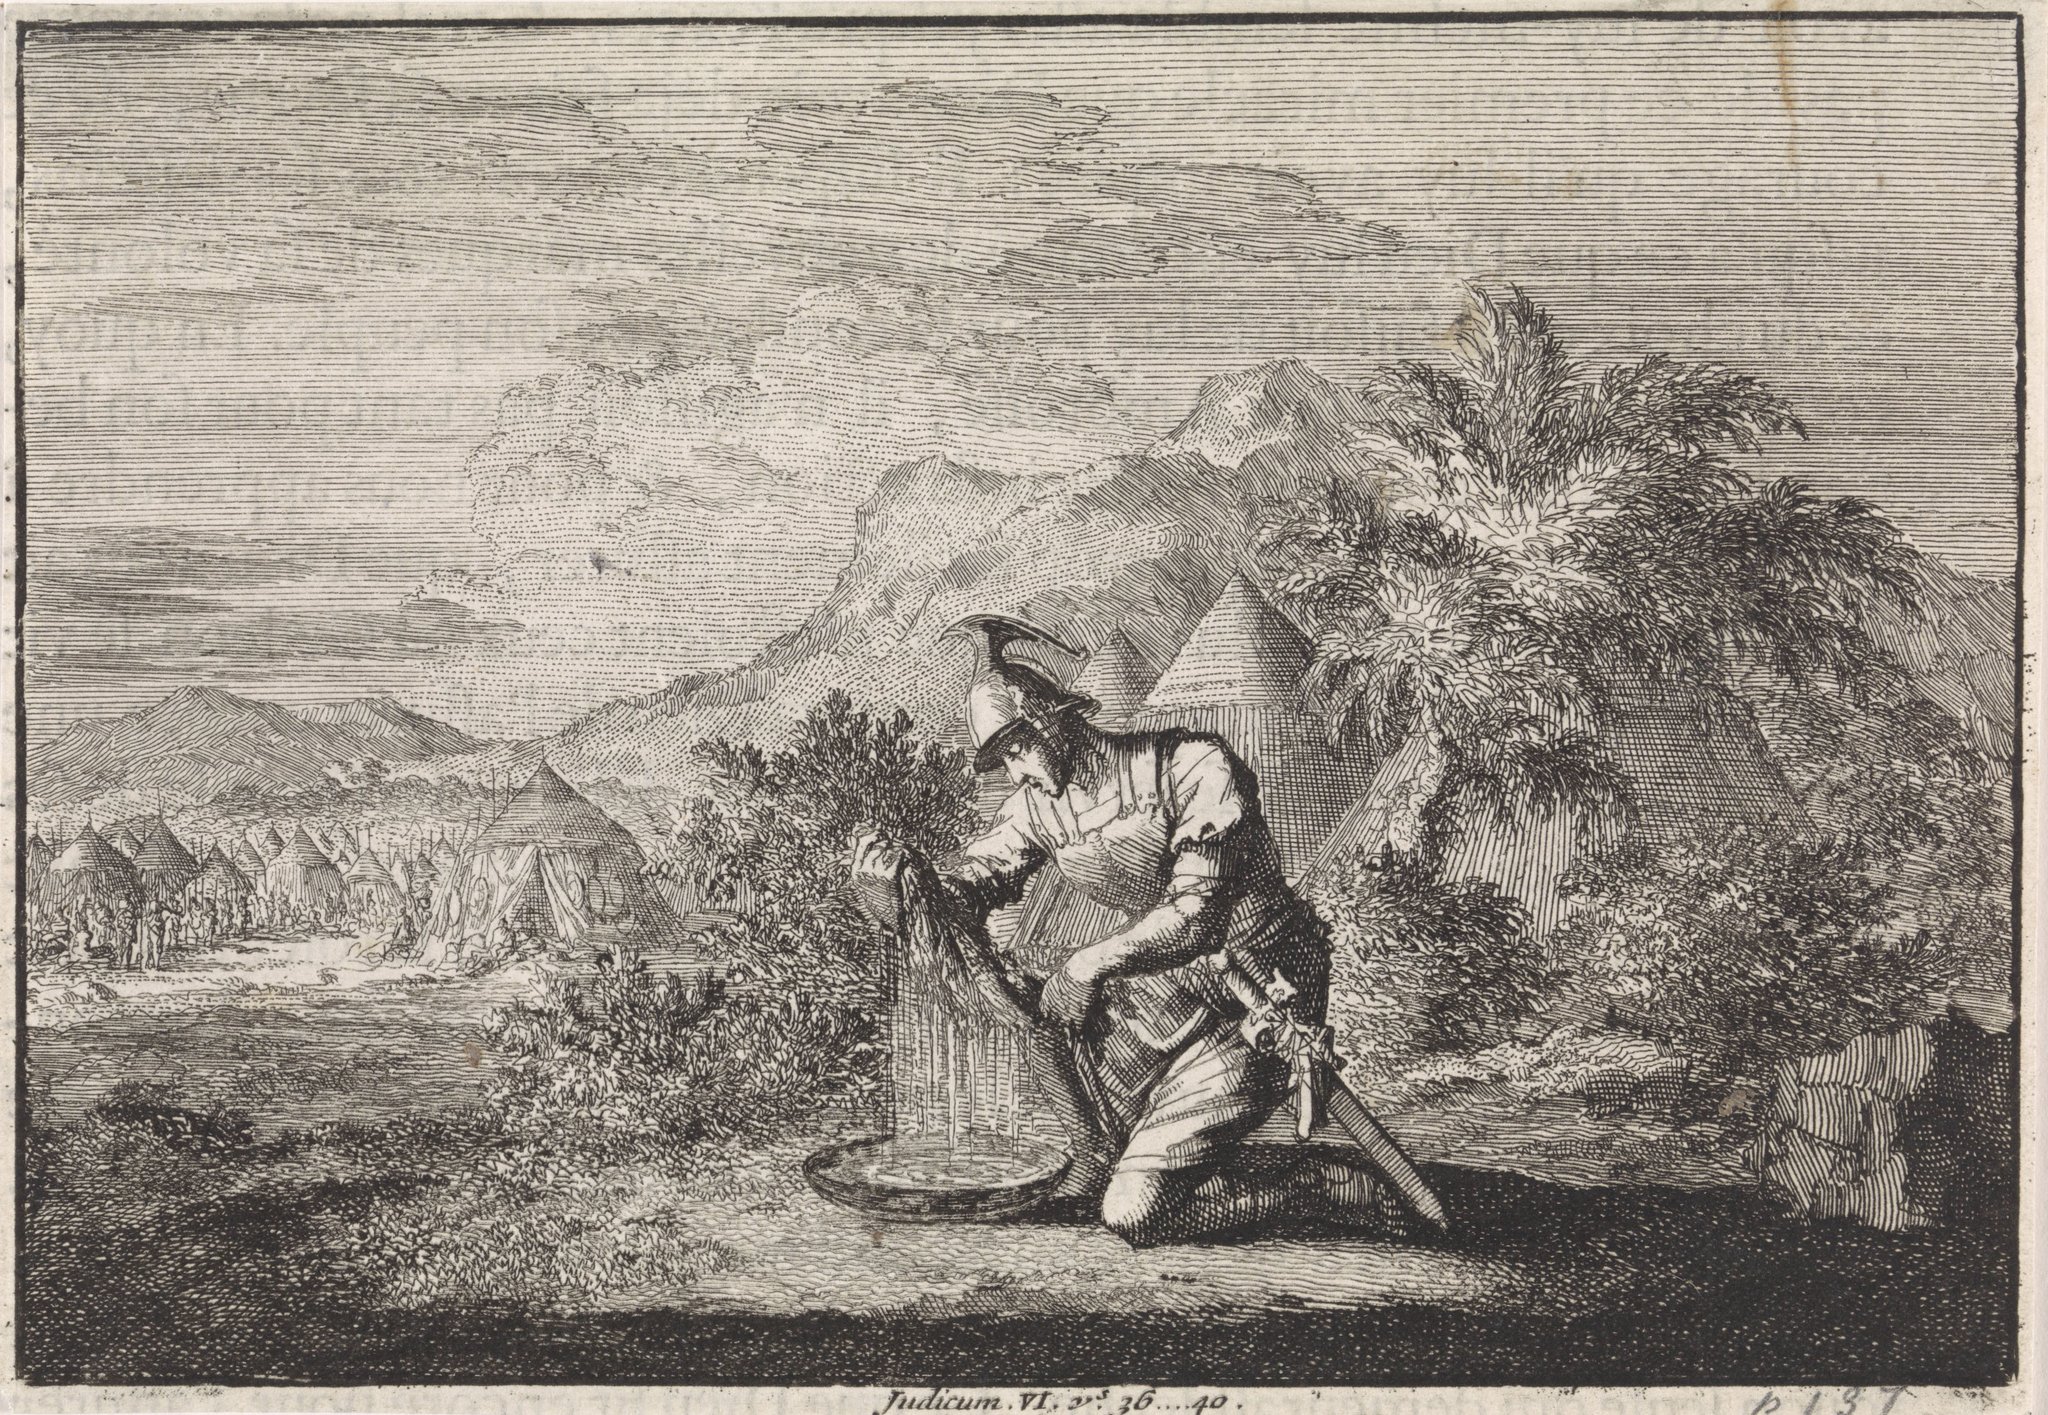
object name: print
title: Gideon en de natte schaapsvacht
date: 1703-1762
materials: paper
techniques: etching, letterpress printing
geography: amsterdam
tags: gideon presses the fleece and wrings out a bowl full of water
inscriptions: collector's mark: Lugt 2228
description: De prent komt een eerste keer voor als boekillustratie voor David Martin. Historie des Ouden en Nieuwen Testaments. Amsterdam, Pieter Mortier, 1703. Deel I. De boekillustraties voor de Mortierbijbel hebben verschillende staten en kopieën, waarbij de chronologische volgorde moeilijk te achterhalen valt. Als boekillustraties werden ze bovendien herhaaldelijk opnieuw gebruikt voor andere boekwerken.